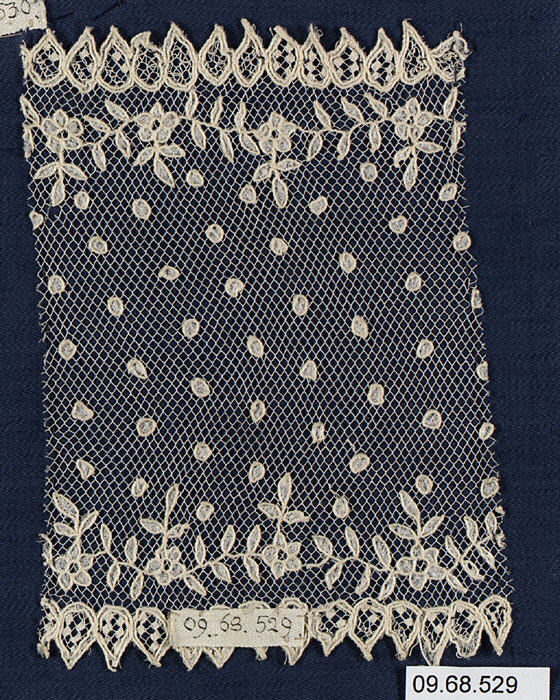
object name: fragment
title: Fragment of lace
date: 1801-1900